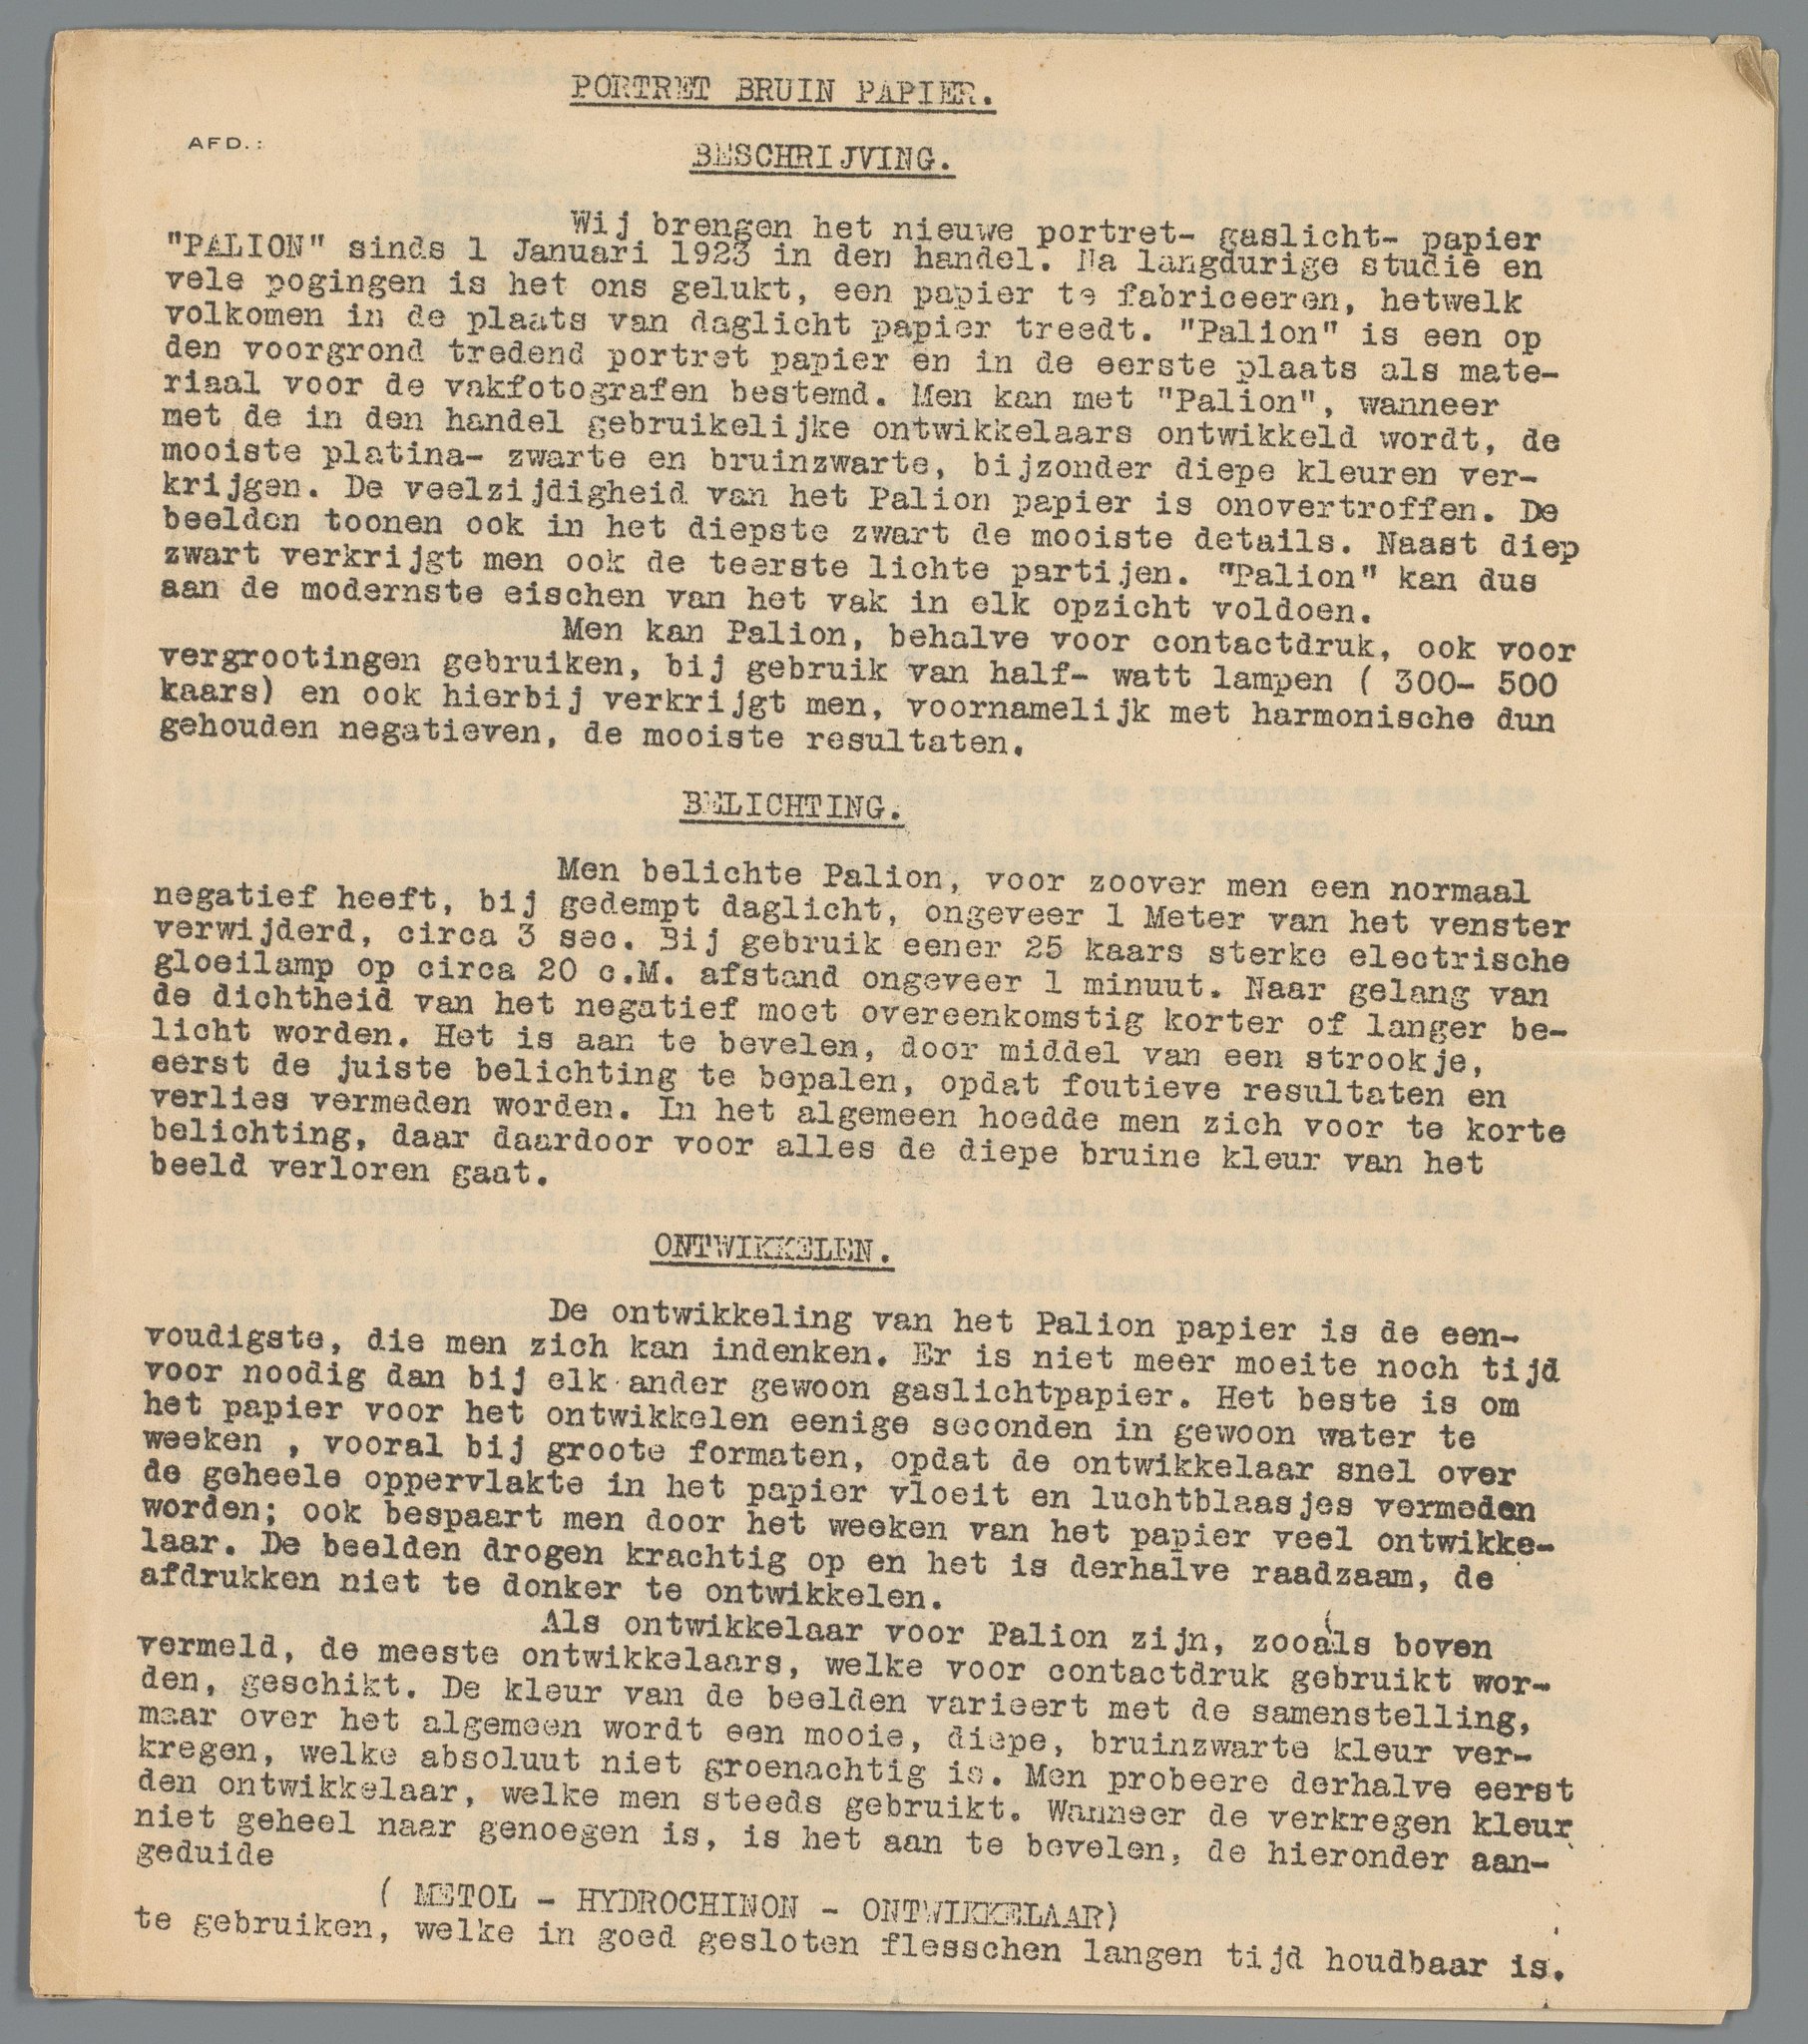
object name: document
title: Portret bruin papier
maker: Anonymous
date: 1923-1924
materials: paper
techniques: typewriting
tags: printing ~ film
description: Handleiding bestaande uit drie pagina's met een beschrijving van het belichten en ontwikkelen van Palion-ontwikkelpapier, wat op 1 januari 1923 op de markt is gebracht.